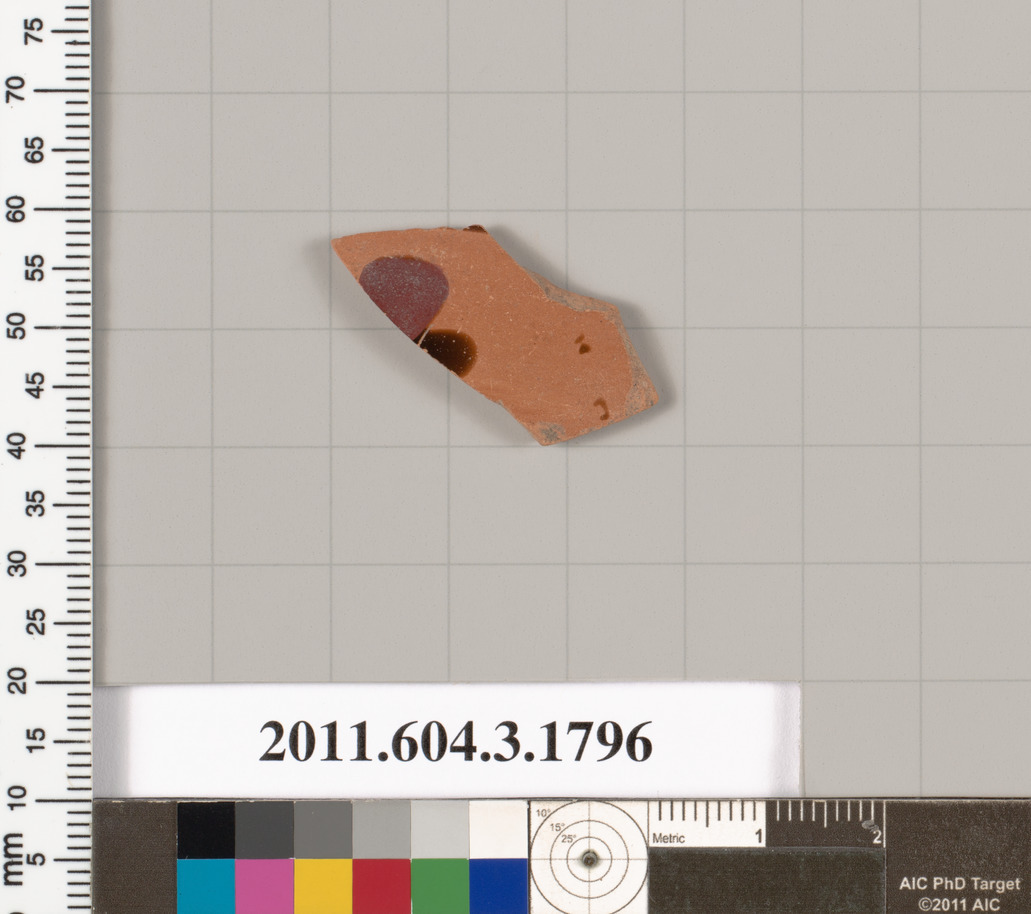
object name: kylix fragment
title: Terracotta fragment of a kylix: Lip cup (drinking cup)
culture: greek, attic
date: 567-535 BCE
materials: terracotta